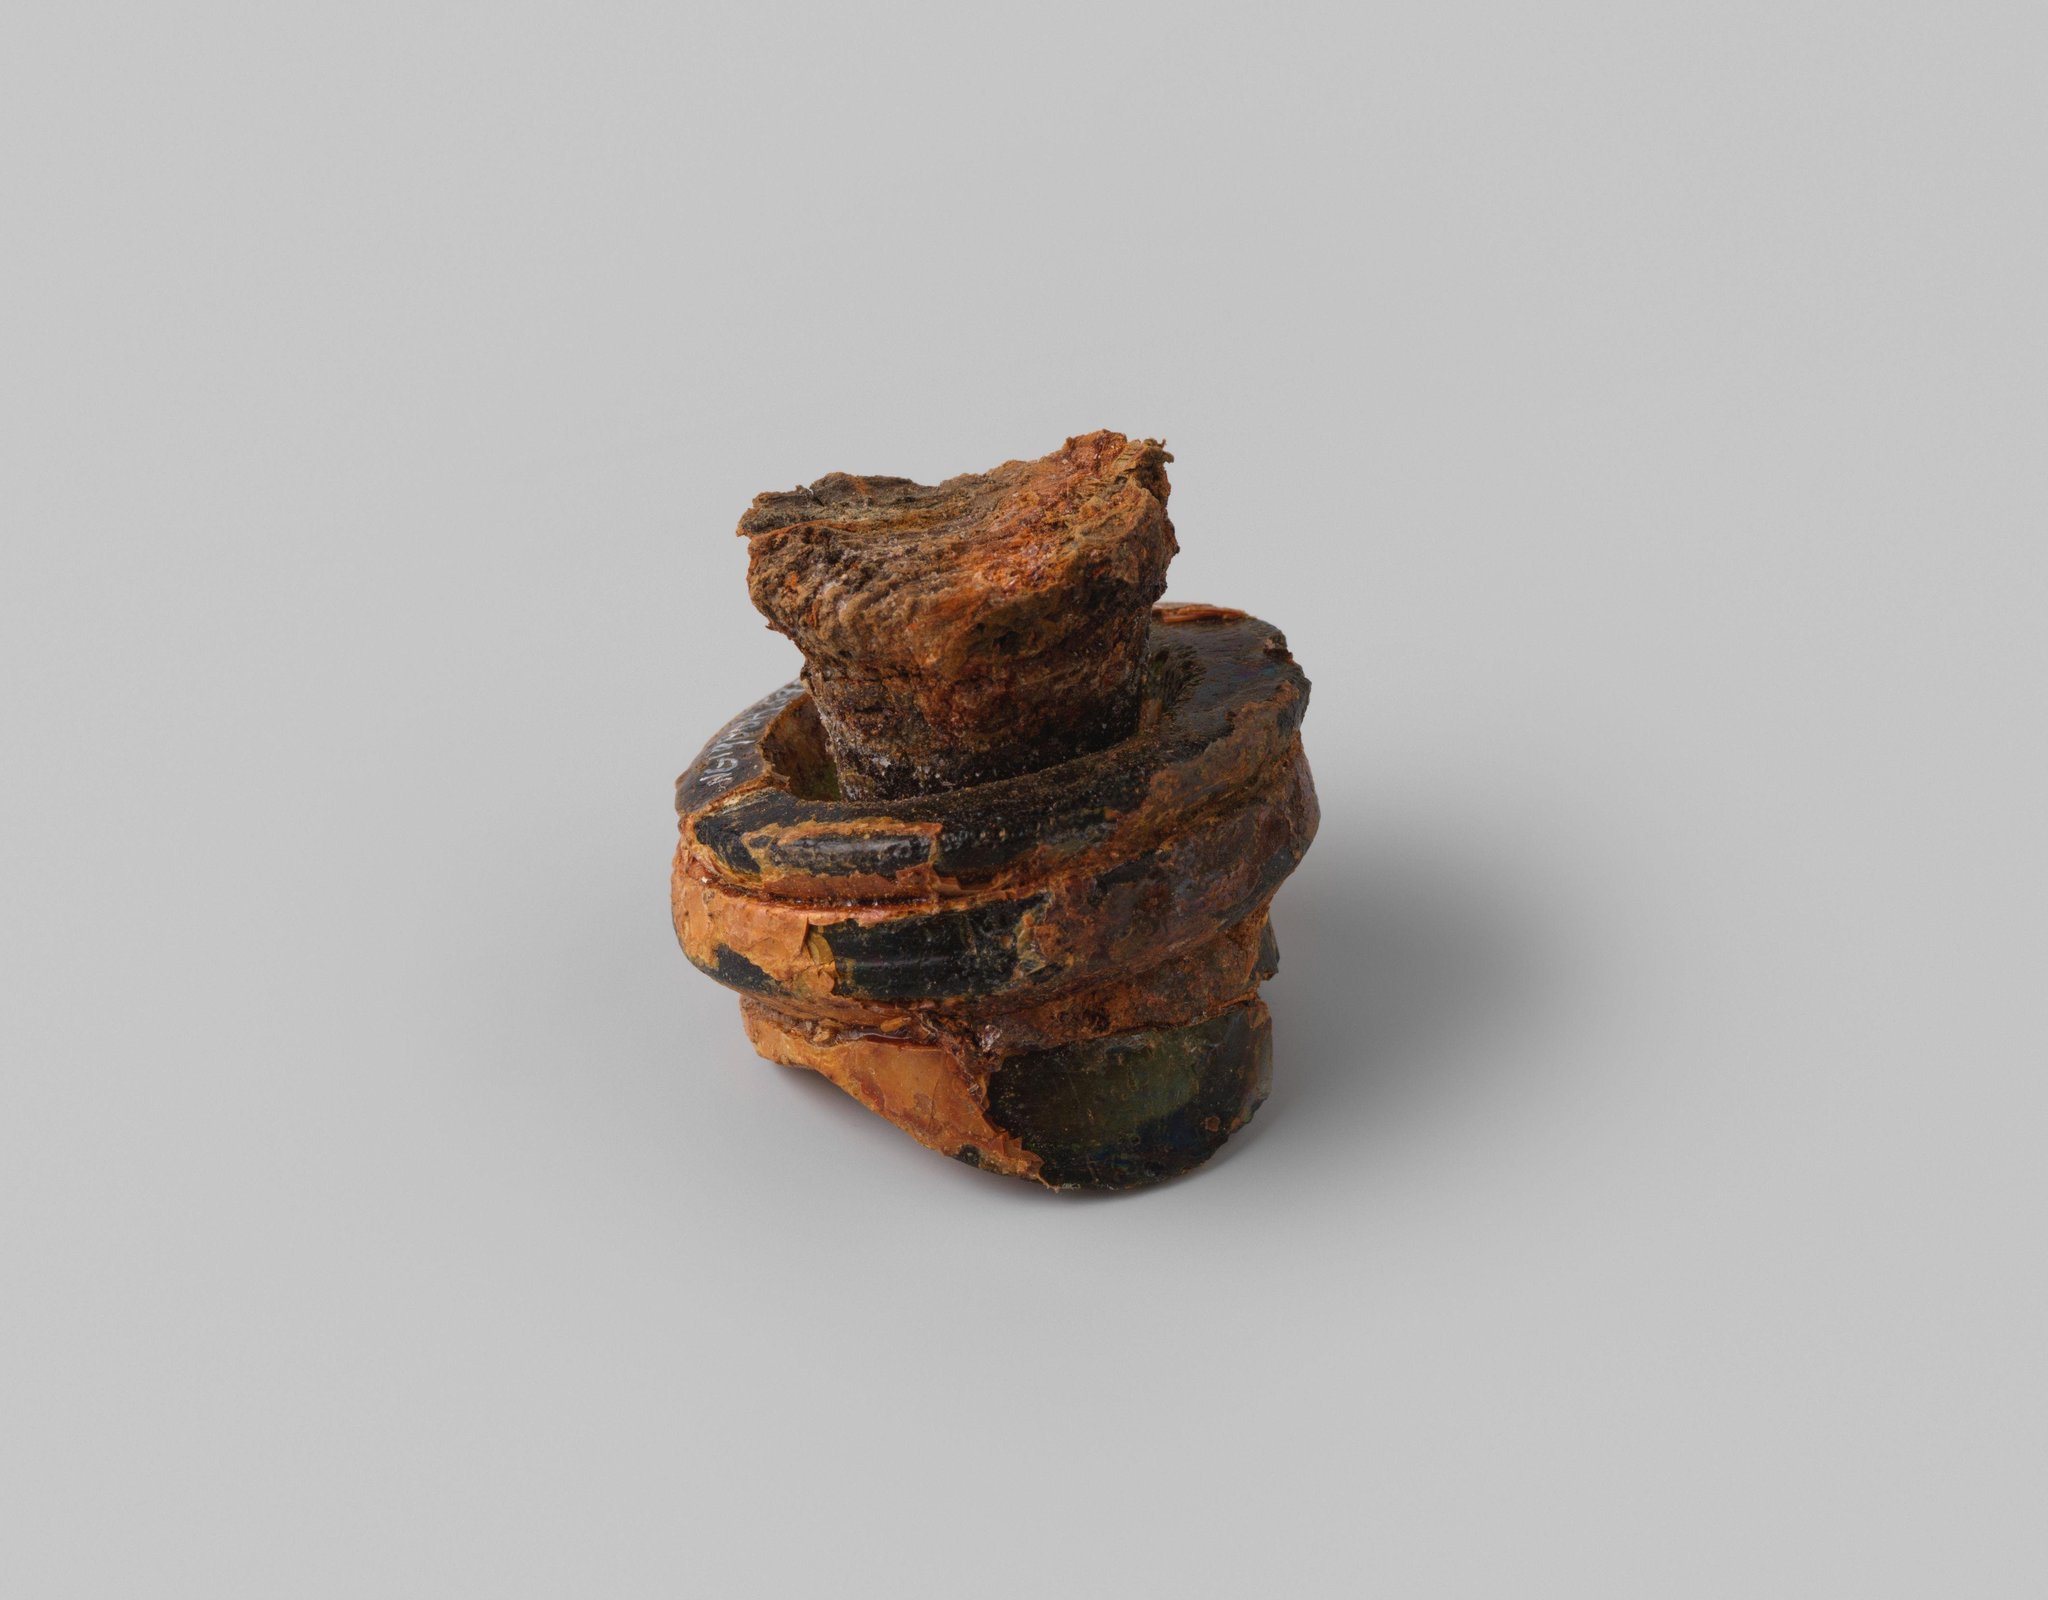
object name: wine bottle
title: Fragment hals met kurk van een wijnfles uit het wrak van de Oost-Indiëvaarder Hollandia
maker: Anonymous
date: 1700-1743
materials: cork, glass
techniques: green glass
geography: netherlands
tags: verenigde oostindische compagnie, hollandia (schip), annet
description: Wine bottle, continental production, neck, onion-shaped bottle or bottle with vertical side; fragm, mouth, vs-string rim, with cork.